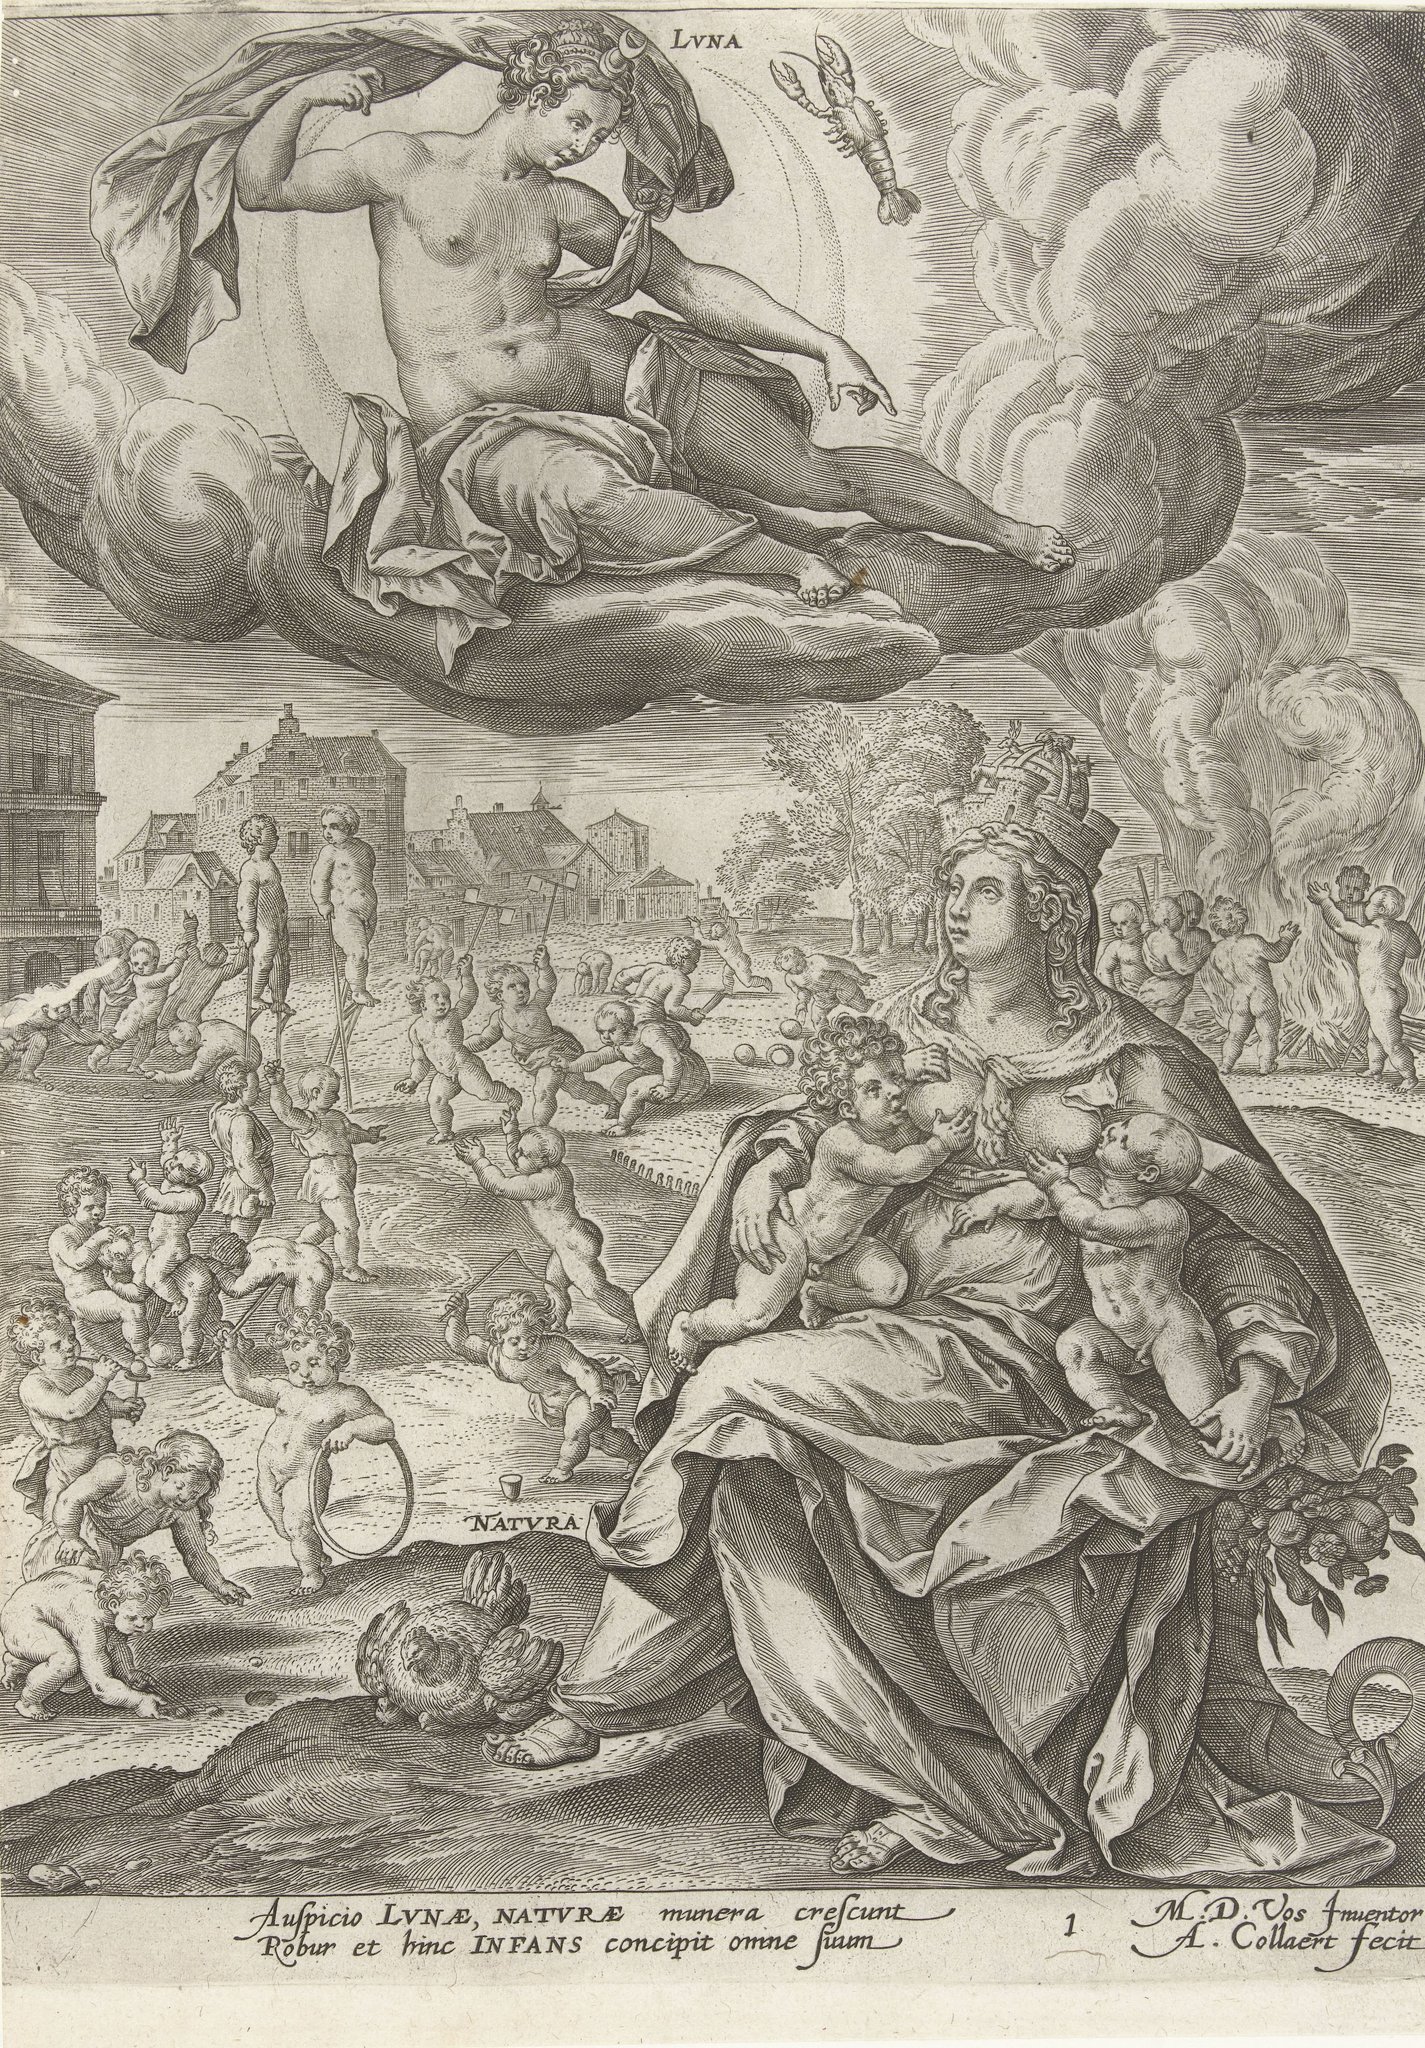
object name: print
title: Septem planetae, septem hominis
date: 1581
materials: paper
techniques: engraving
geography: antwerp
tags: 'natura' (allegorical figure or scene; or as diana of ephesus, with many breasts); 'natura' (ripa), children's games and plays, luna and her children ('planetenkinder') ~ cancer, the first years ~ the ages of man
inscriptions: collector's mark: Lugt 2228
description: In de lucht zweeft de planeetgodin Luna. de maan. Ze is vergezeld door de Kreeft, haar astrologisch teken. Op de voorgrond de personificatie van Natura, de natuur. Ze zoogt twee kinderen en heeft een moederkloek en een cornucopia als attributen. Haar stedenkroon identificeert haar tevens als Cybele, moeder der goden. Op de achtergrond spelen kleuters en peuters met elkaar. De prent heeft een Latijns onderschrift en is deel van een zevendelige serie over de macht van de zeven planeten over de zeven leeftijden van de mens.